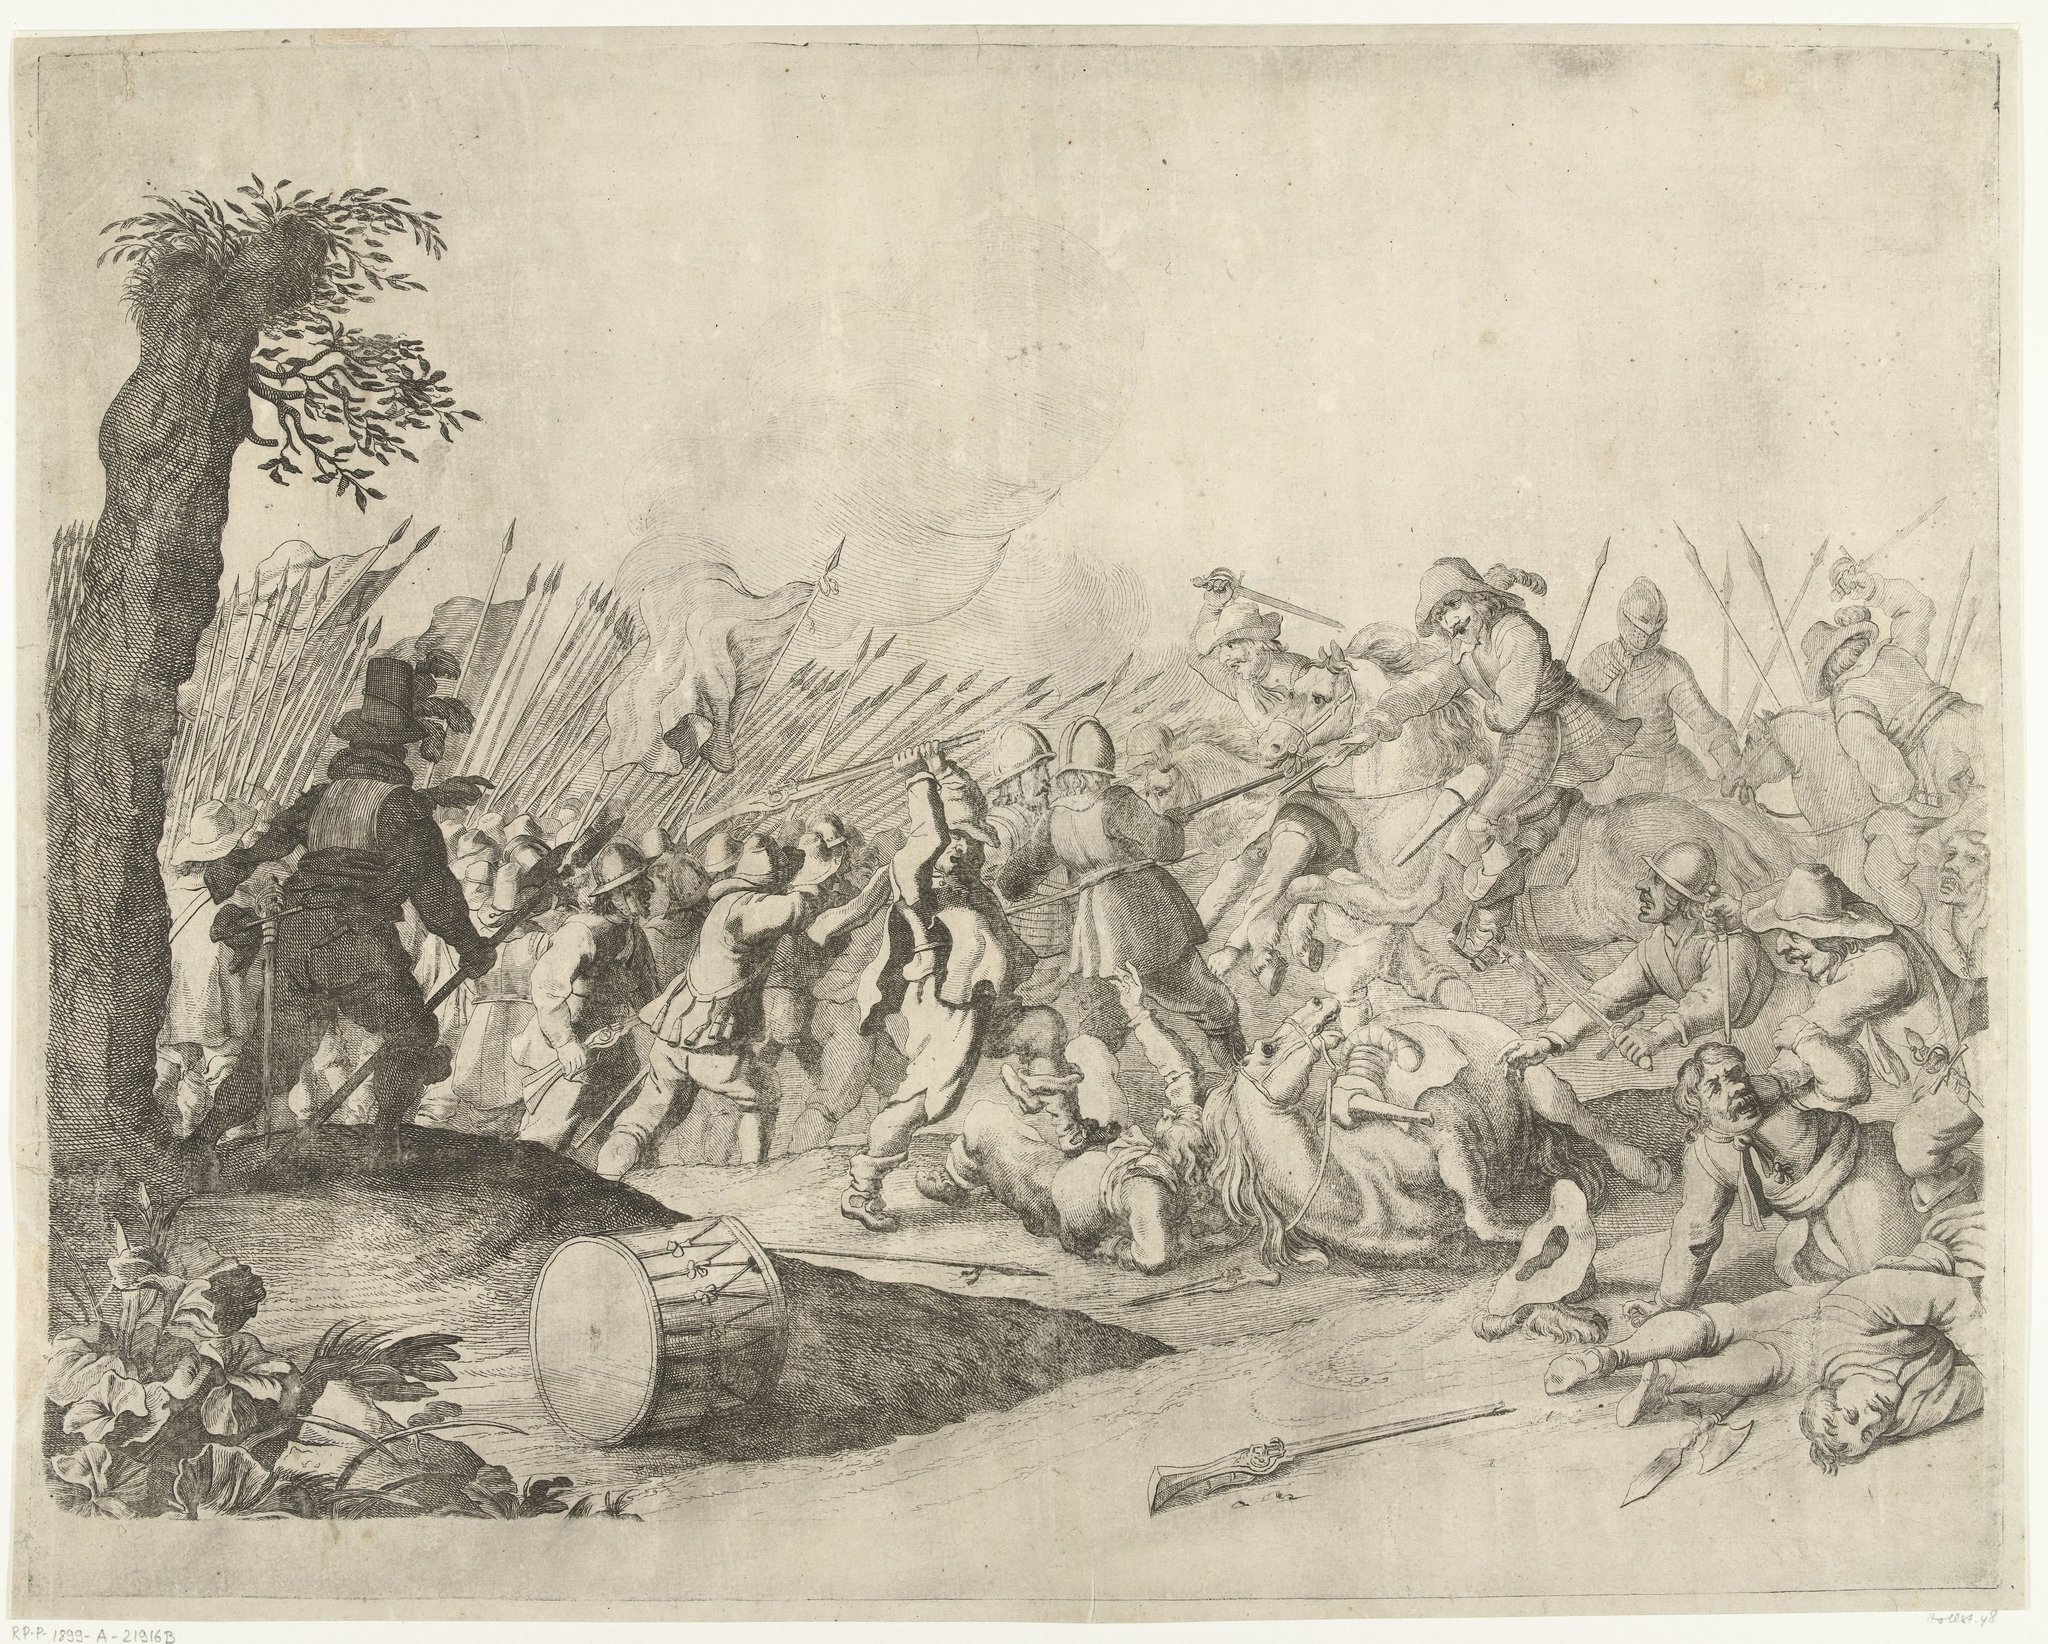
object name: print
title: Gevecht tussen ruiters en voetvolk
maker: willem basse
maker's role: draughtsman, print maker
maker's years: 1613-1672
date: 1633-1672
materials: paper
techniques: etching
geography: amsterdam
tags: battle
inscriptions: collector's mark: Lugt 2228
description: Gezicht op een slagtveld waar een gevecht plaats vindt tussen troepen te paard en infanteristen. Een grote groep infanteristen met lansen komt van links. De soldaten vechten met geweren, pistolen en degens.